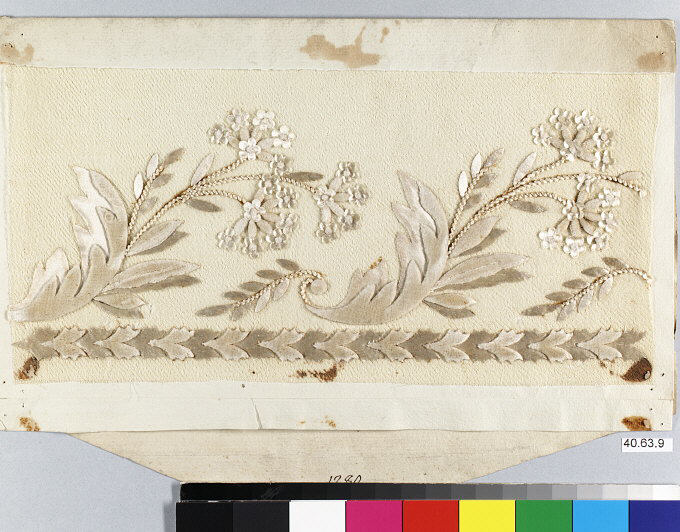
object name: border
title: Dress border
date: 1801-1833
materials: silk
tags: flowers